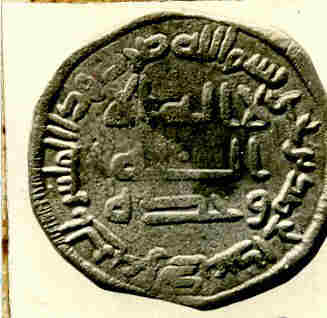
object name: coin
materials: copper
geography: a-rayy